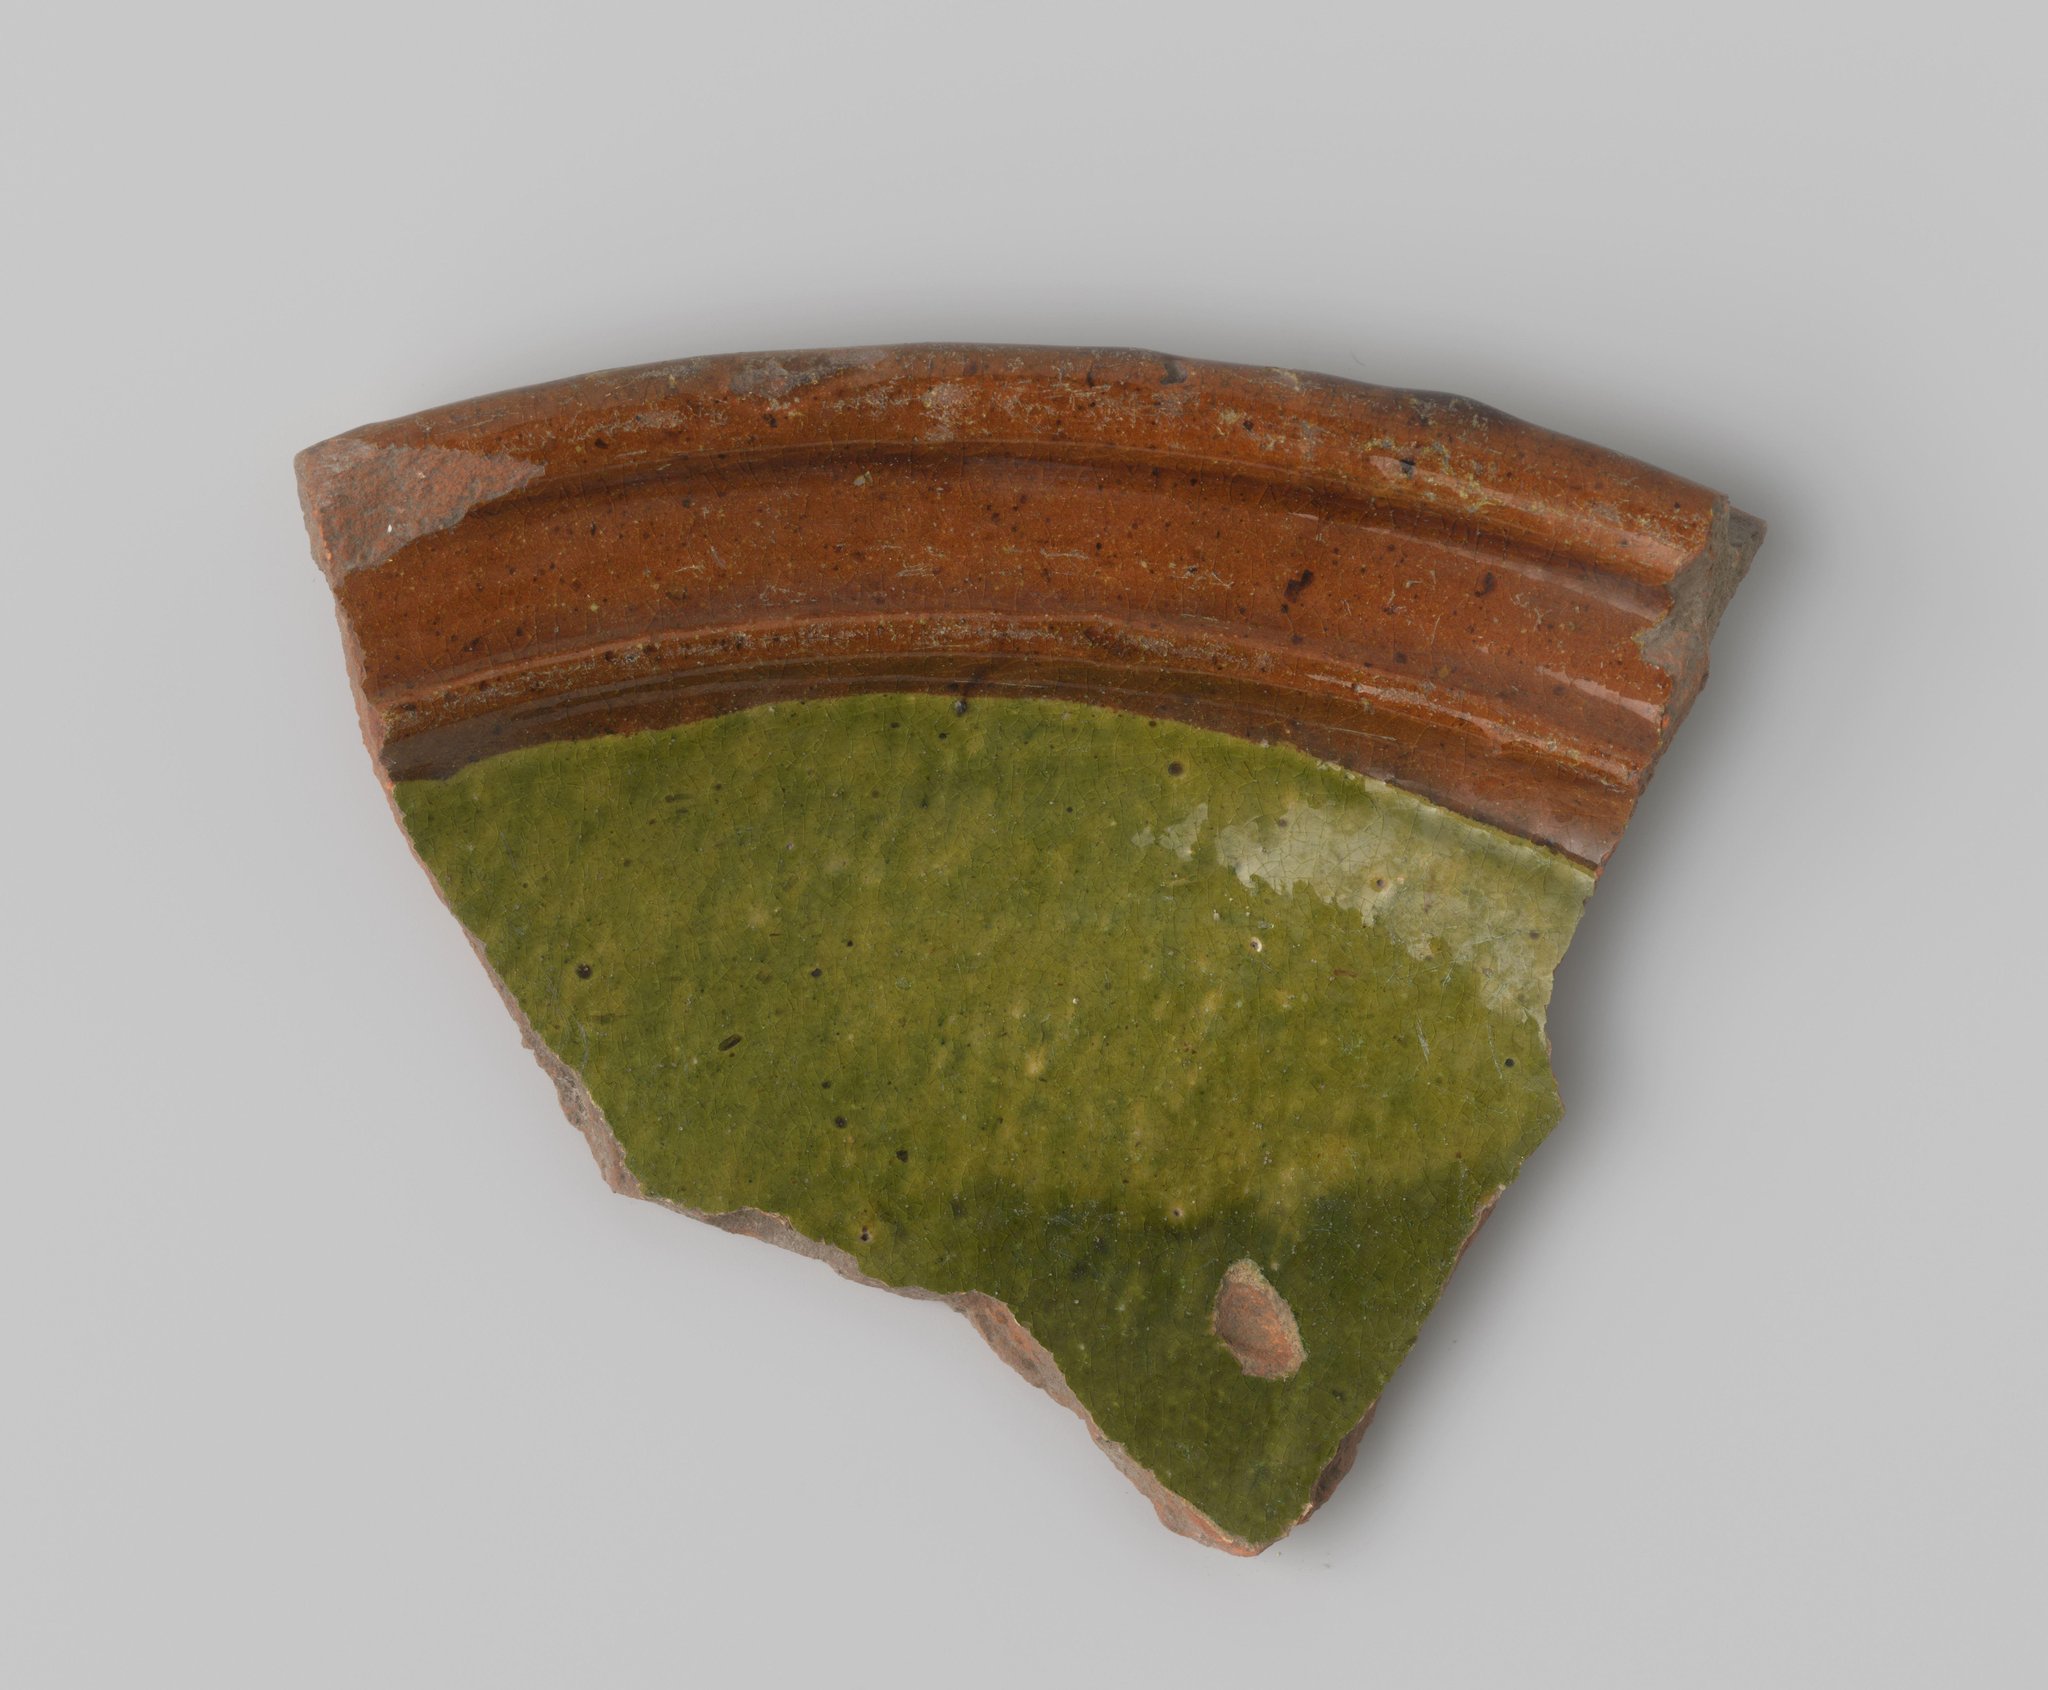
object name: sherd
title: Scherf roodbakkend aardewerk met decoratie in groen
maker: Anonymous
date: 1500-1699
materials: earthenware, glaze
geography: northern netherlands